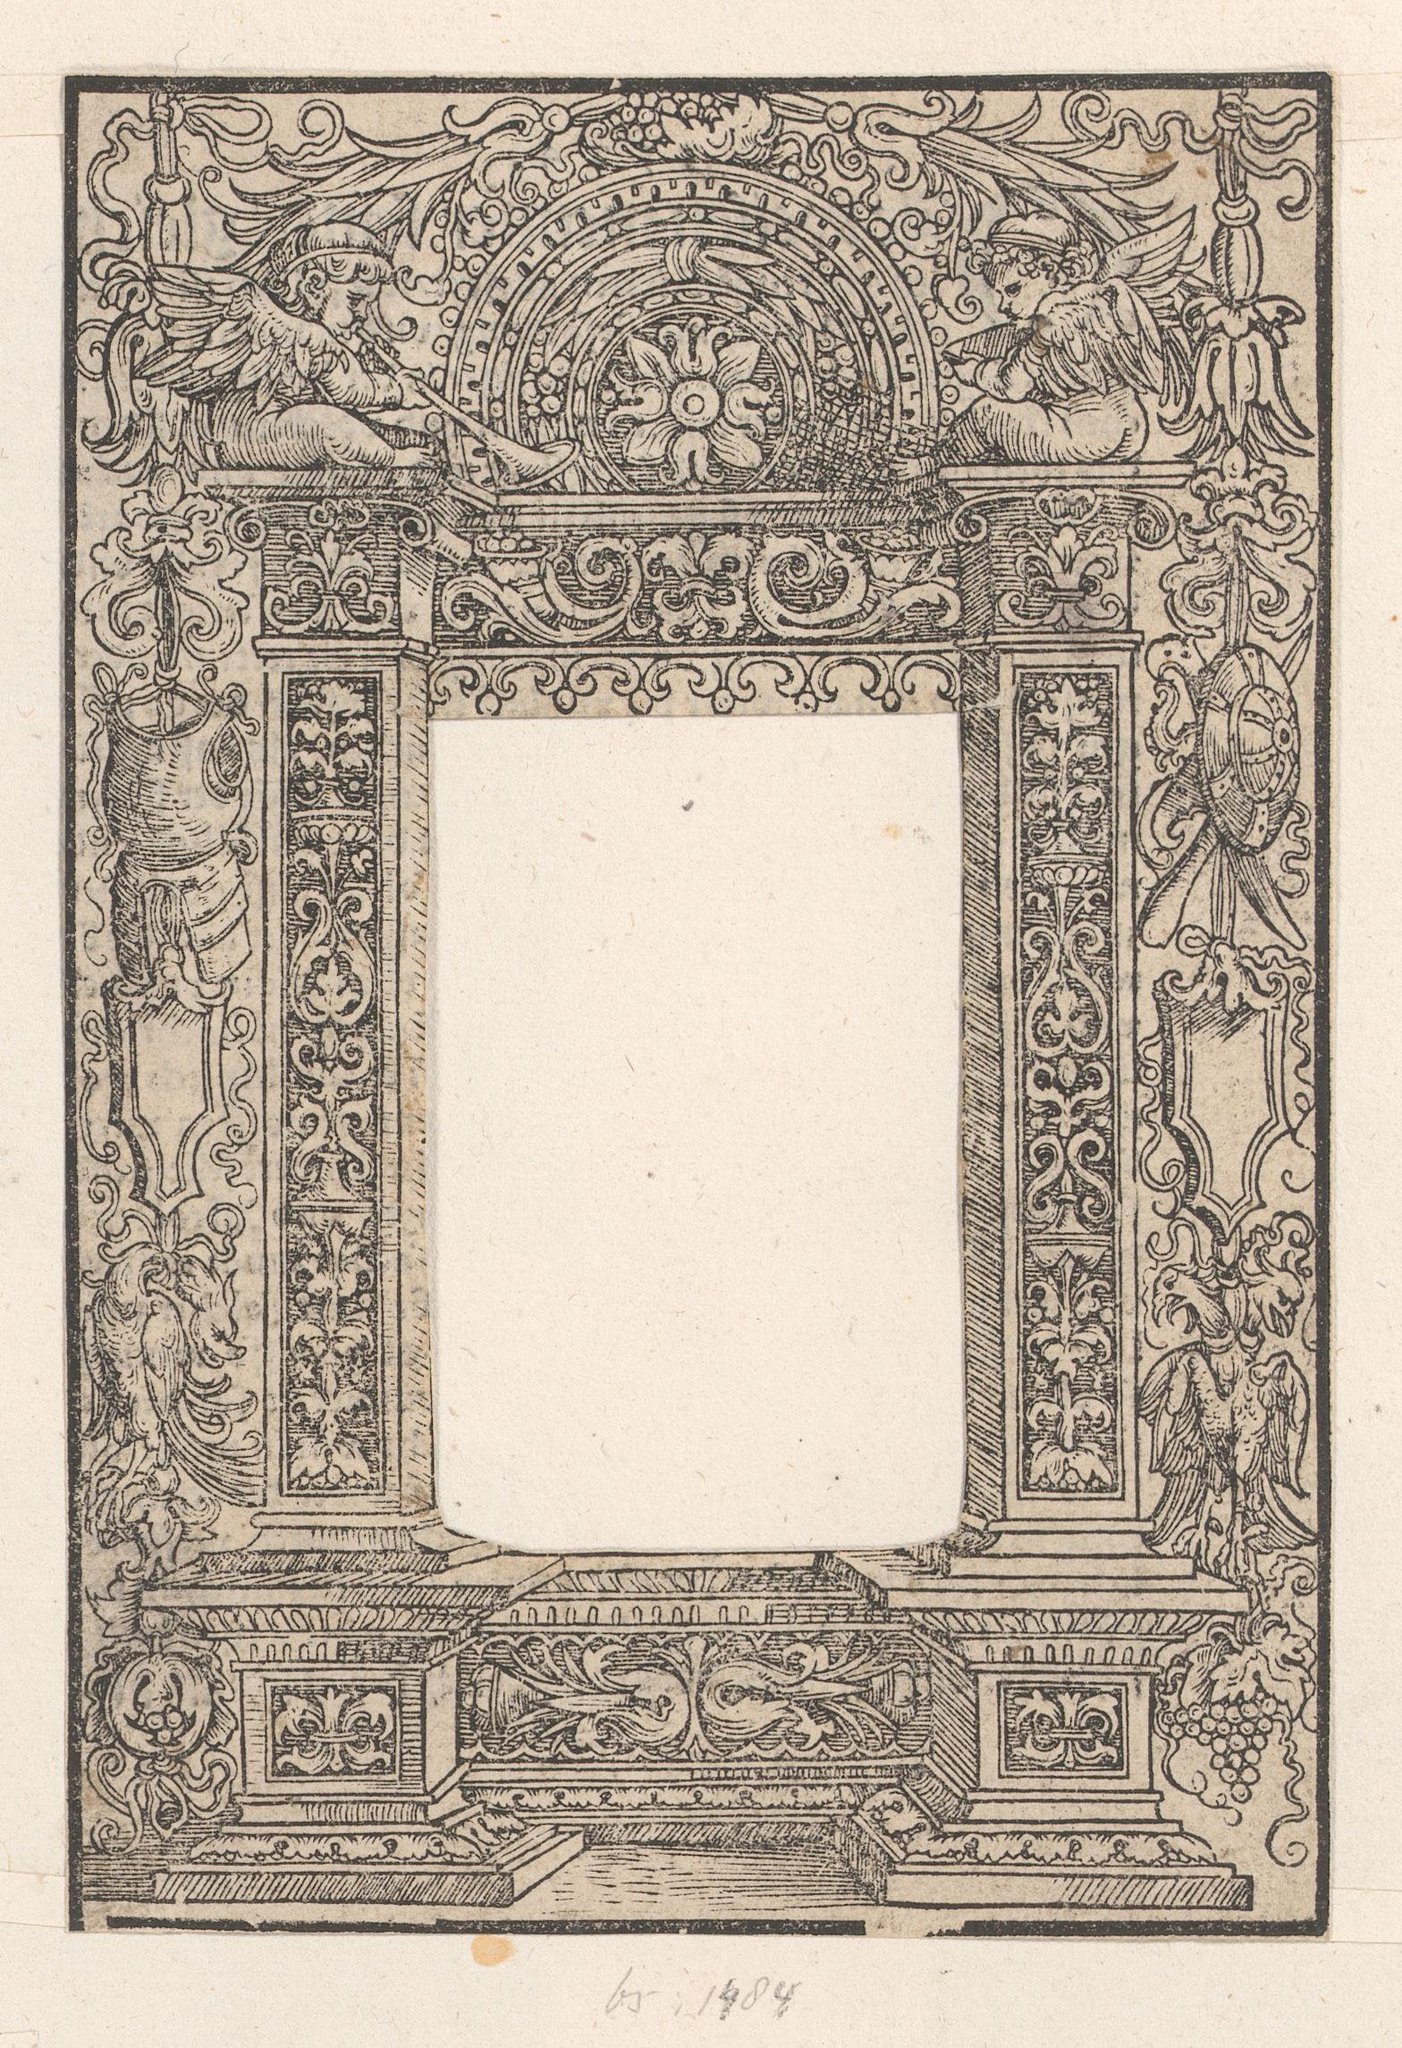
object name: album leaf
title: Titelomlijsting met wapentrofeeën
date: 1522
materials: paper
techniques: woodcut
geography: nuremberg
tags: initial, cupids: 'amores', 'amoretti', 'putti'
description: Gebruikt als titelpagina voor: Biblia Sacra Utriusque Testamenti, Neurenberg: Johann Koberger, 1522.